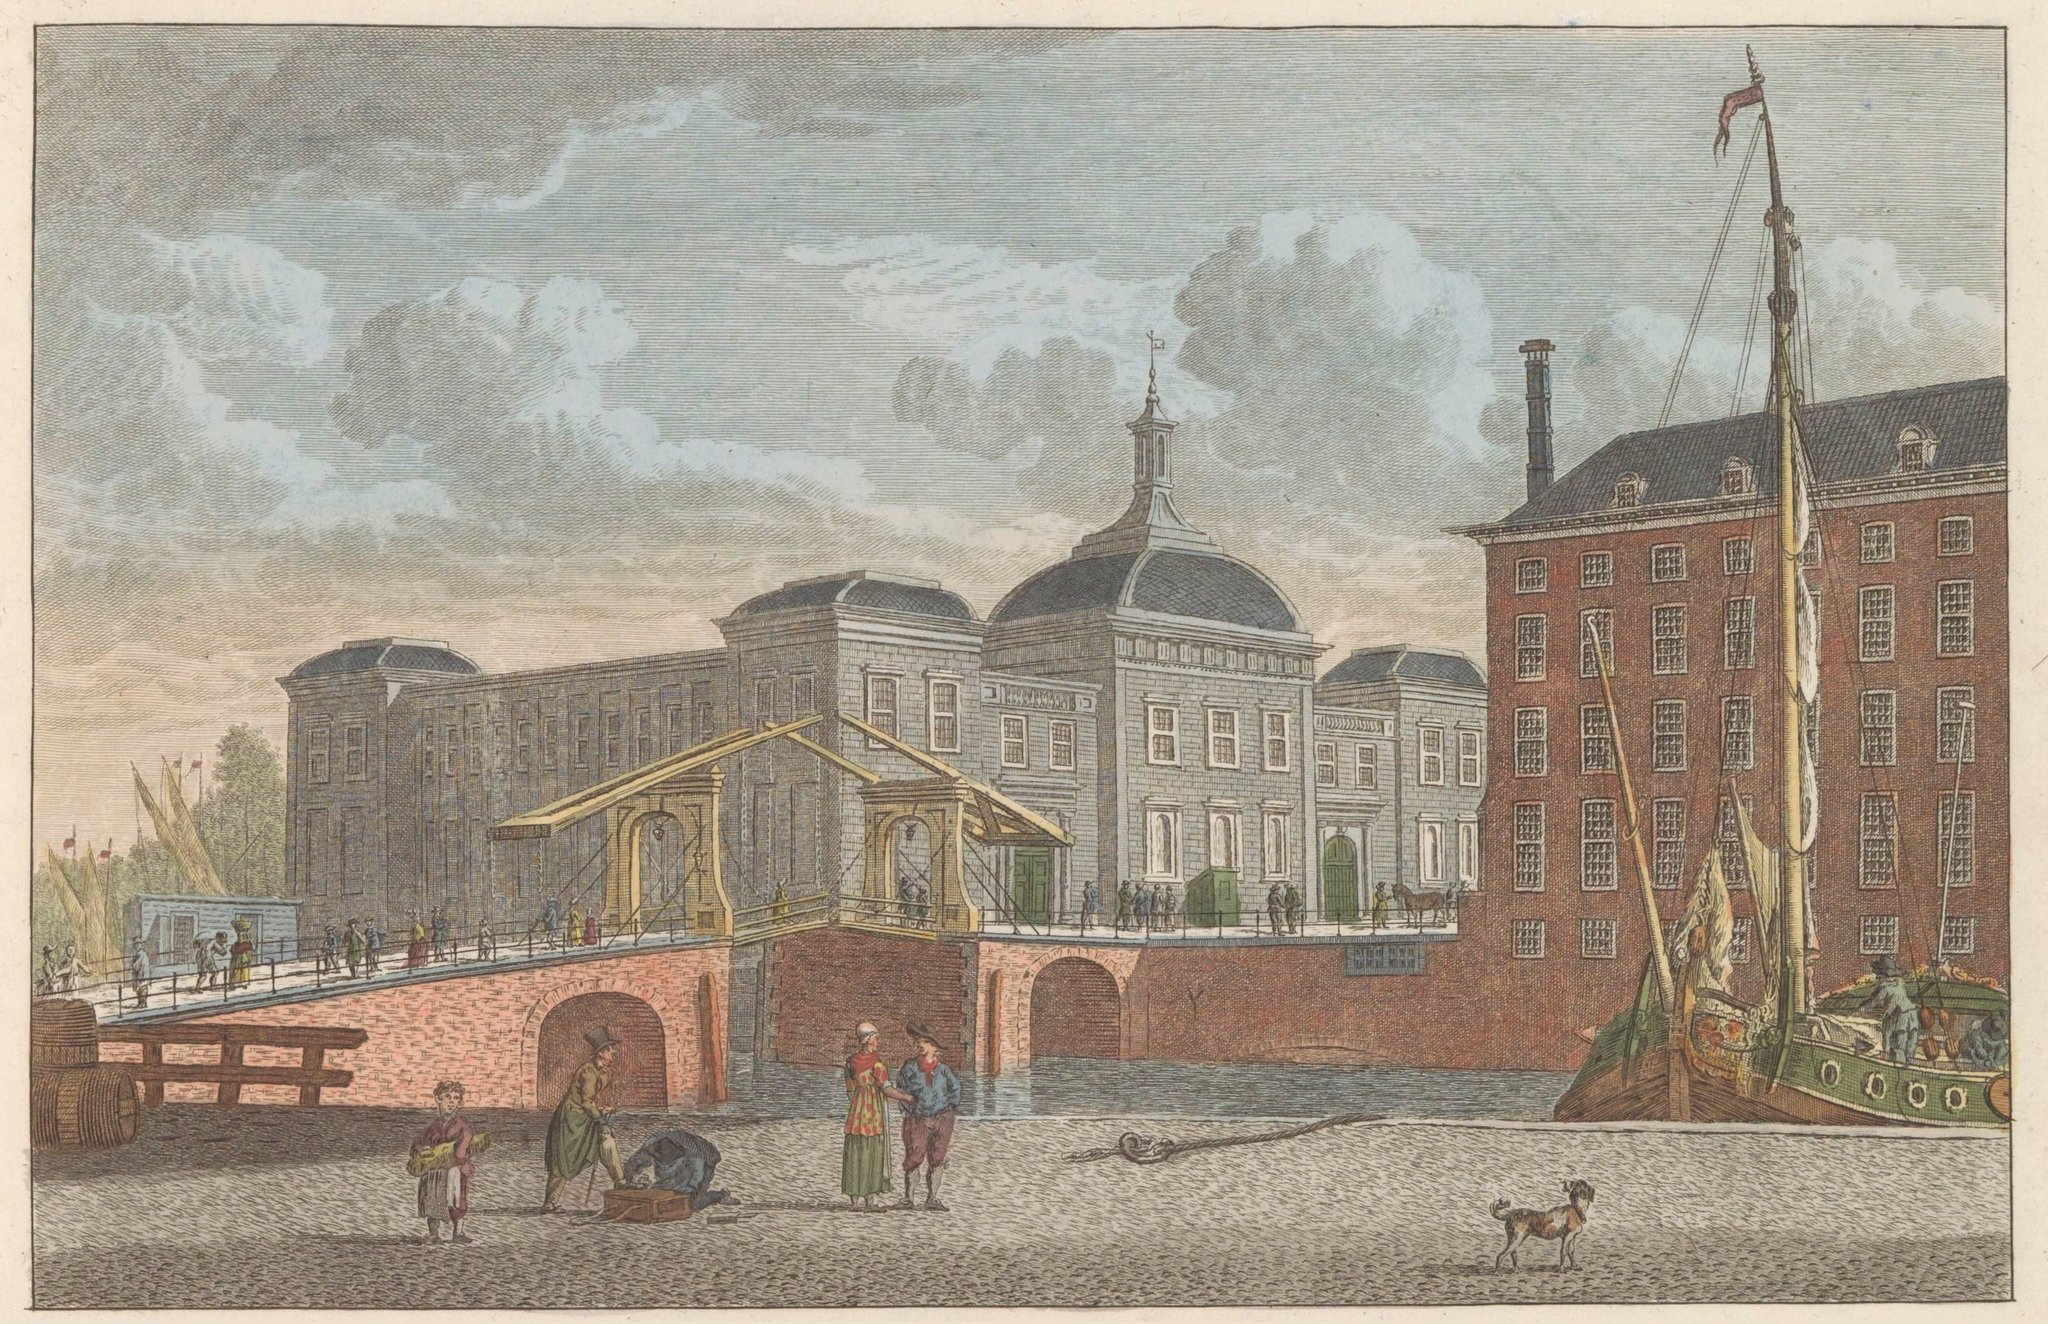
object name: print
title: Beurs te Rotterdam / La Bourse à Rotterdam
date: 1786-1792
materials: paper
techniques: engraving, etching, hand coloring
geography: amsterdam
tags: stock exchange, stock-market, rotterdam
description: Huidige staat van prent uitgegeven als onderdeel van een plaatwerk uit ca. 1824-1825 met 74 (ongenummerde) platen van de belangrijkste topografische gezichten en verschillende zeden en gewoonten in het Verenigd Koninkrijk der Nederlanden, getiteld 'Tableau des principales vues des palais et édifices : représentations et des coutumes et usages, dans les provinces septentrionales du Royaume des Pays-Bas'. Eerdere staat gebruikt in: Vaderlandsche gezichten, of afbeeldingen van den tegenwoordigen staat der Vereenigde Nederlanden (…). Amsterdam: Hendrik Gartman, Willem Vermandel en Jan Willem Smit, 1786-1792. Uitgegeven in afleveringen met ieder een eigen bifolium en inhoudsopgave. Alle prenten in deze publicatie zijn gegraveerd door Carel Frederik Bendorp (I) en, in de meeste gevallen, gebaseerd op tekeningen van Jan Bulthuis.